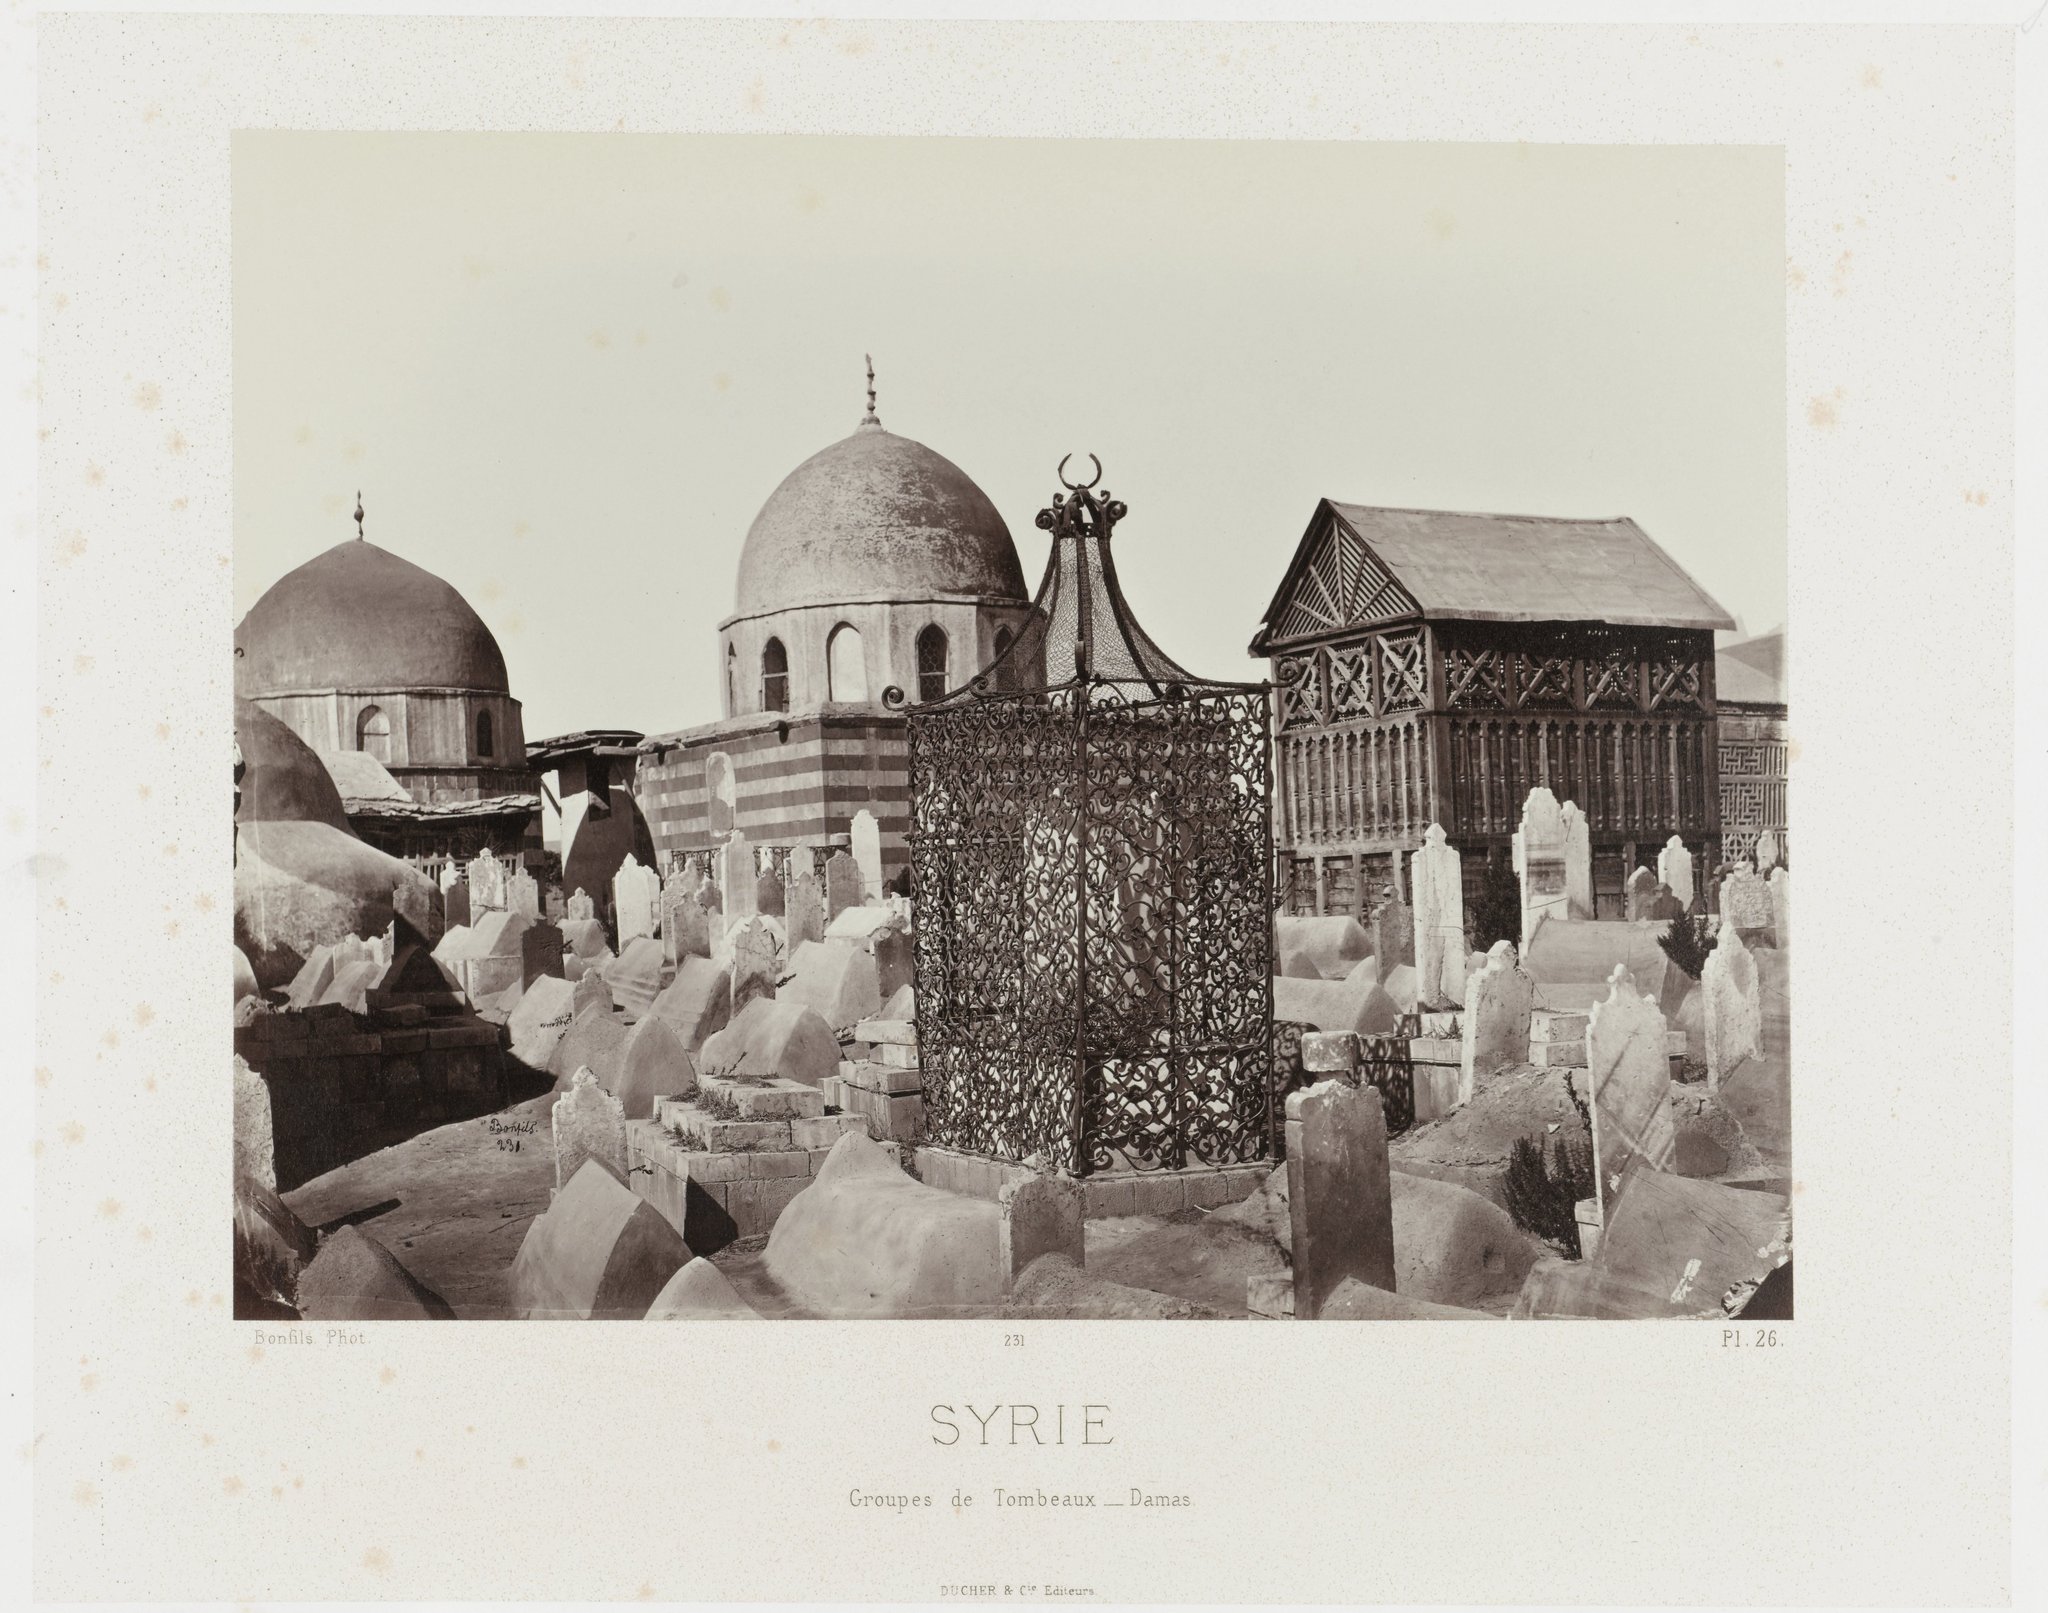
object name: photograph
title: Gezicht op een begraafplaats in Damascus (Syrie/Groupes de Tombeaux - Damas)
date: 1872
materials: cardboard, paper, photographic support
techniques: albumen print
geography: syria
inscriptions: stamp: ‘Rijksschool voor Kunstnijverheid’, signature: ‘Bonfils phot’, number: ‘Bonfils 231’, number: ‘231’, number: ‘Pl. 26’, title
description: Syrie/Groupes de Tombeaux - Damas Pl. 26.